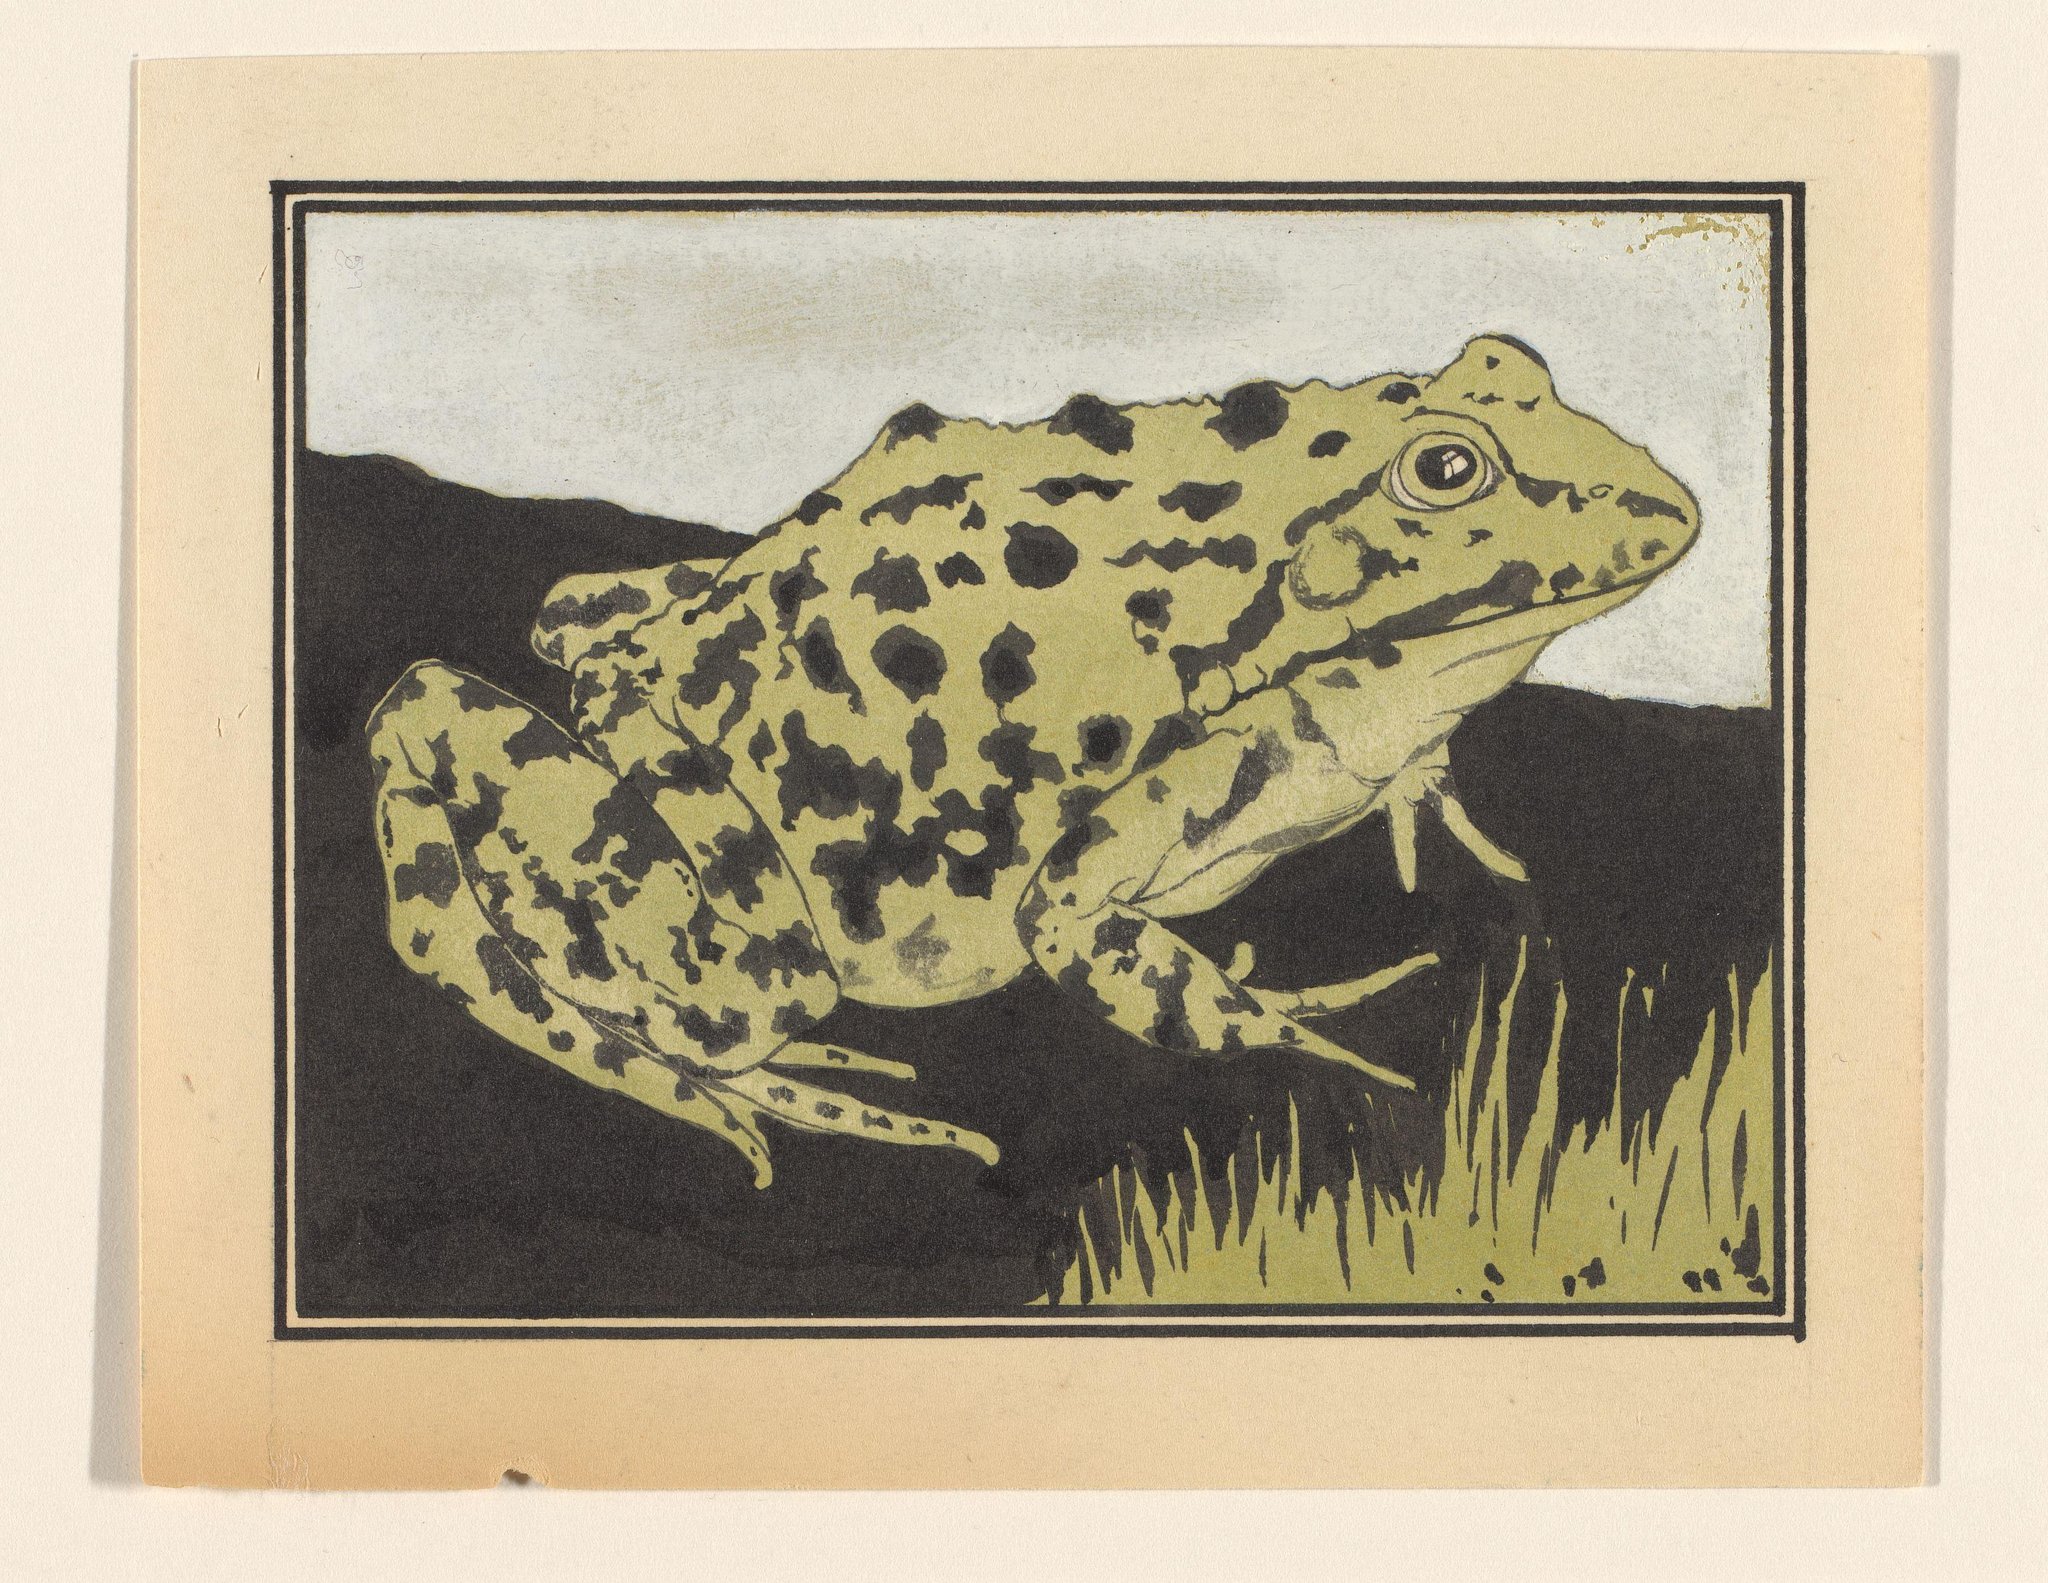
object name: drawing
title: Kikker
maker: julie de graag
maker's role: draughtsman, print maker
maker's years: 1877-1924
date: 1887-1924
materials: paint, ink, paper, watercolor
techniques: brush, pen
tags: tailless amphibians: frog